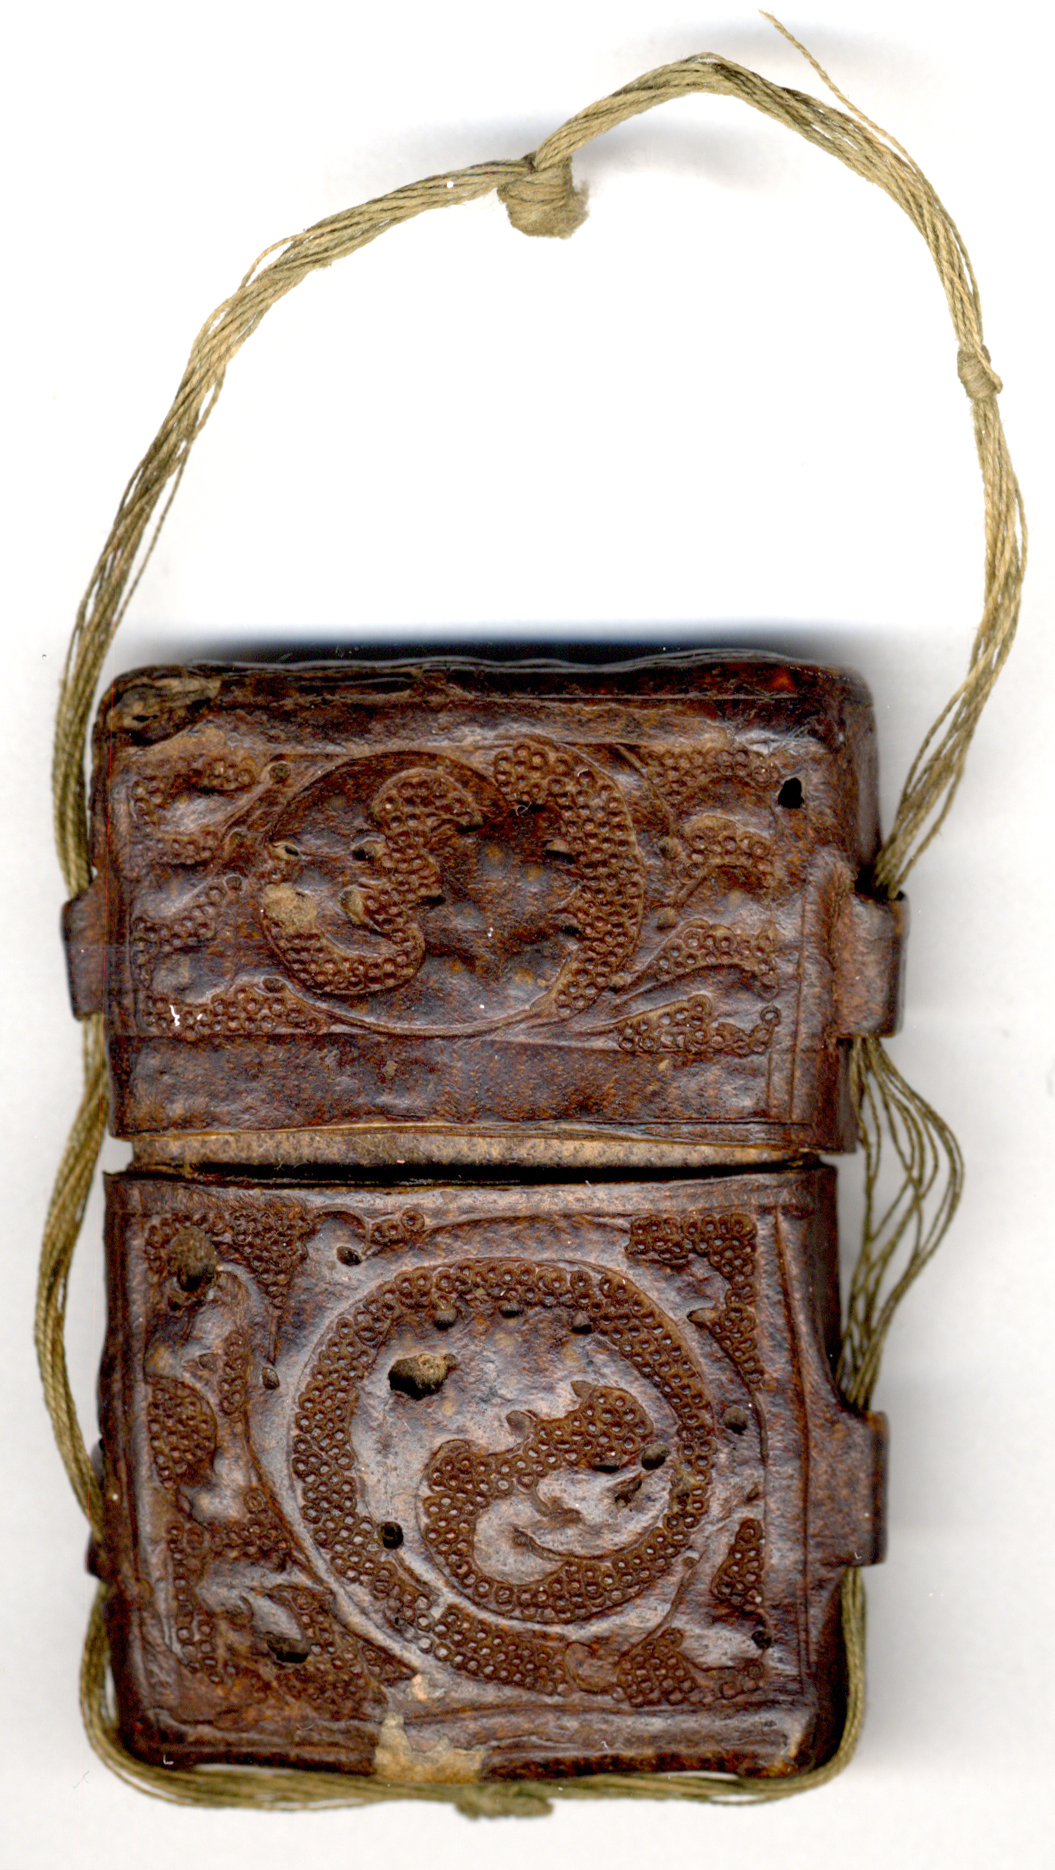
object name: case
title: Case for Enamel Diptych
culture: british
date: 1301-1400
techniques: tooling